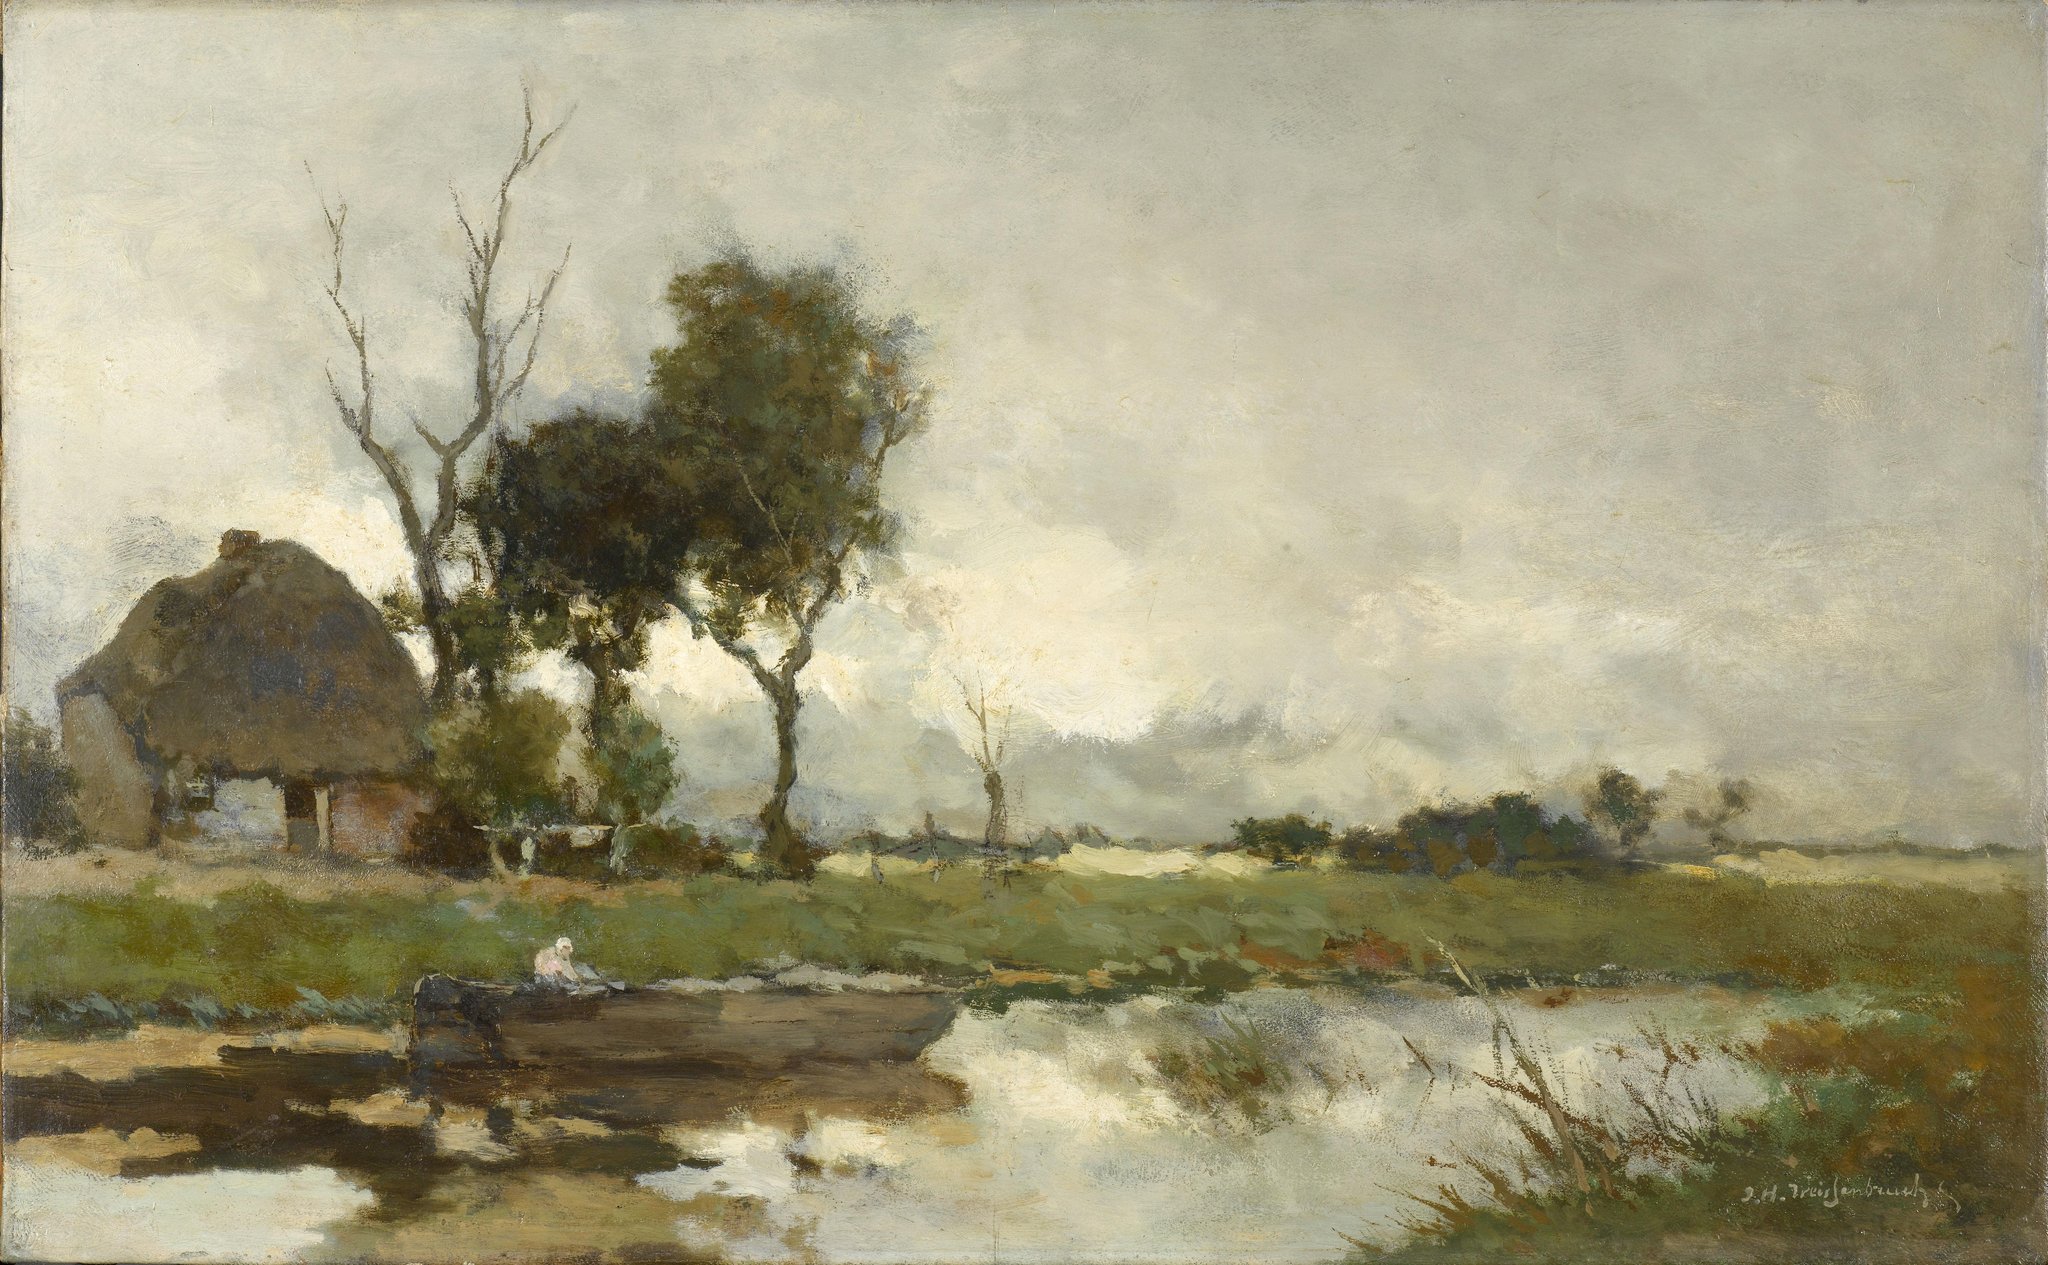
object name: painting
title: Autumn Landscape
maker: johan hendrik weissenbruch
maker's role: draughtsman, painter, print maker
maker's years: 1824-1903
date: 1875-1903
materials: canvas, oil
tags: rowing-boat, canoe, etc., farm or solitary house in landscape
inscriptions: signature: ‘J.H. Weissenbruch f’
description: Weissenbruch spent a great deal of time in the village of Noorden along the Nieuwkoop lakes, where he ventured out to sketch, even in poor weather. He worked up these sketches later in his studio. In Autumn Landscape the paint layers were applied wet-on-wet in an ultimate attempt to capture on canvas the damp atmosphere of the Dutch polder landscape.